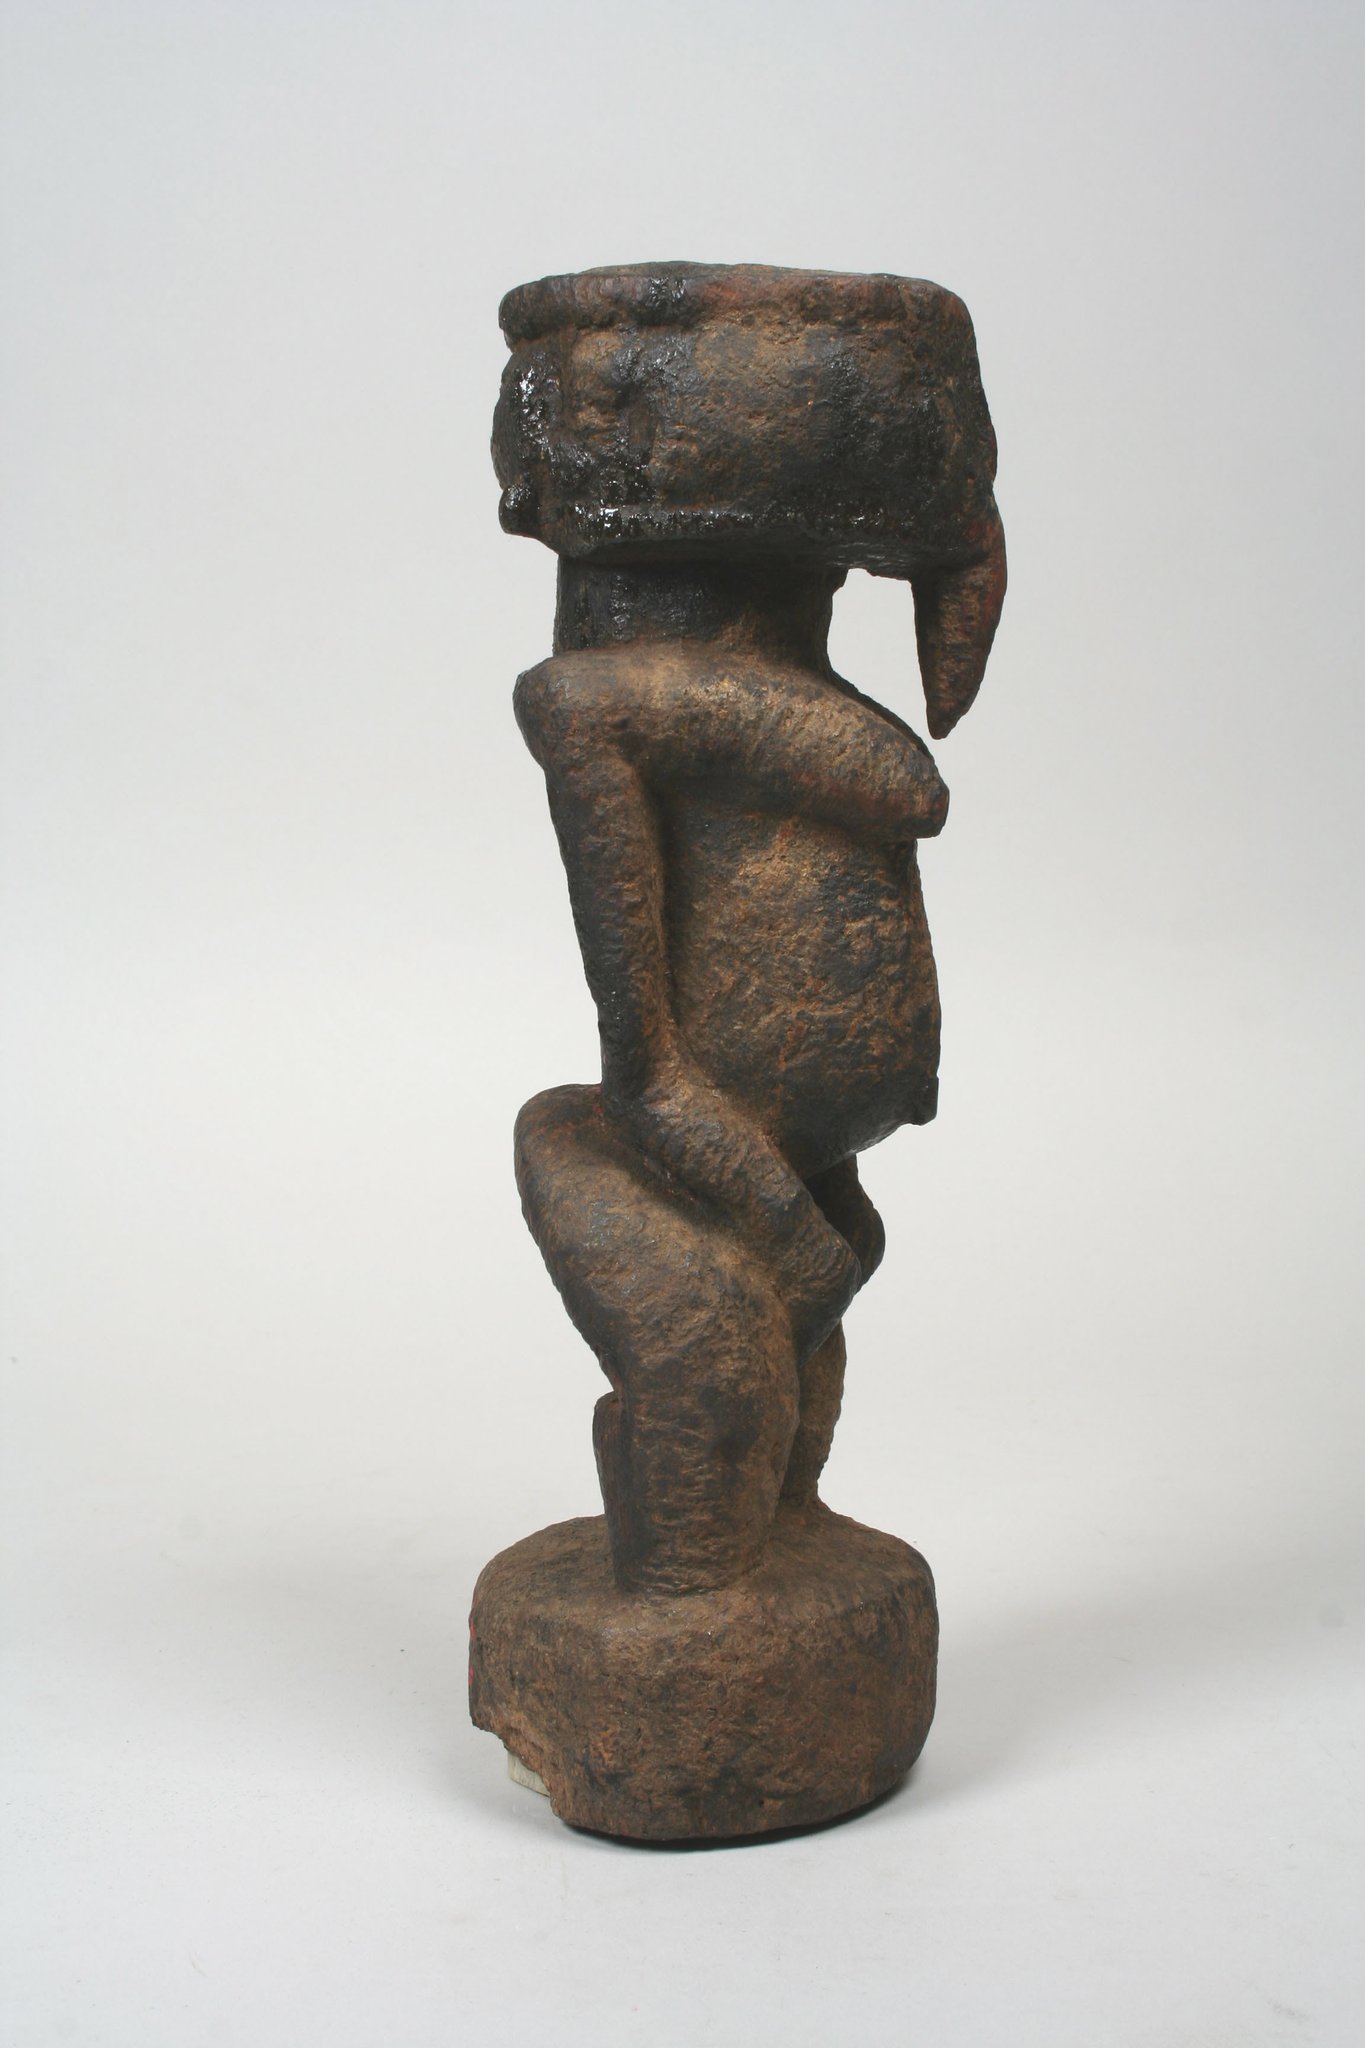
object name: figure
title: Figure: Female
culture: dogon or tellem peoples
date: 1401-1900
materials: wood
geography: mali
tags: female nudes